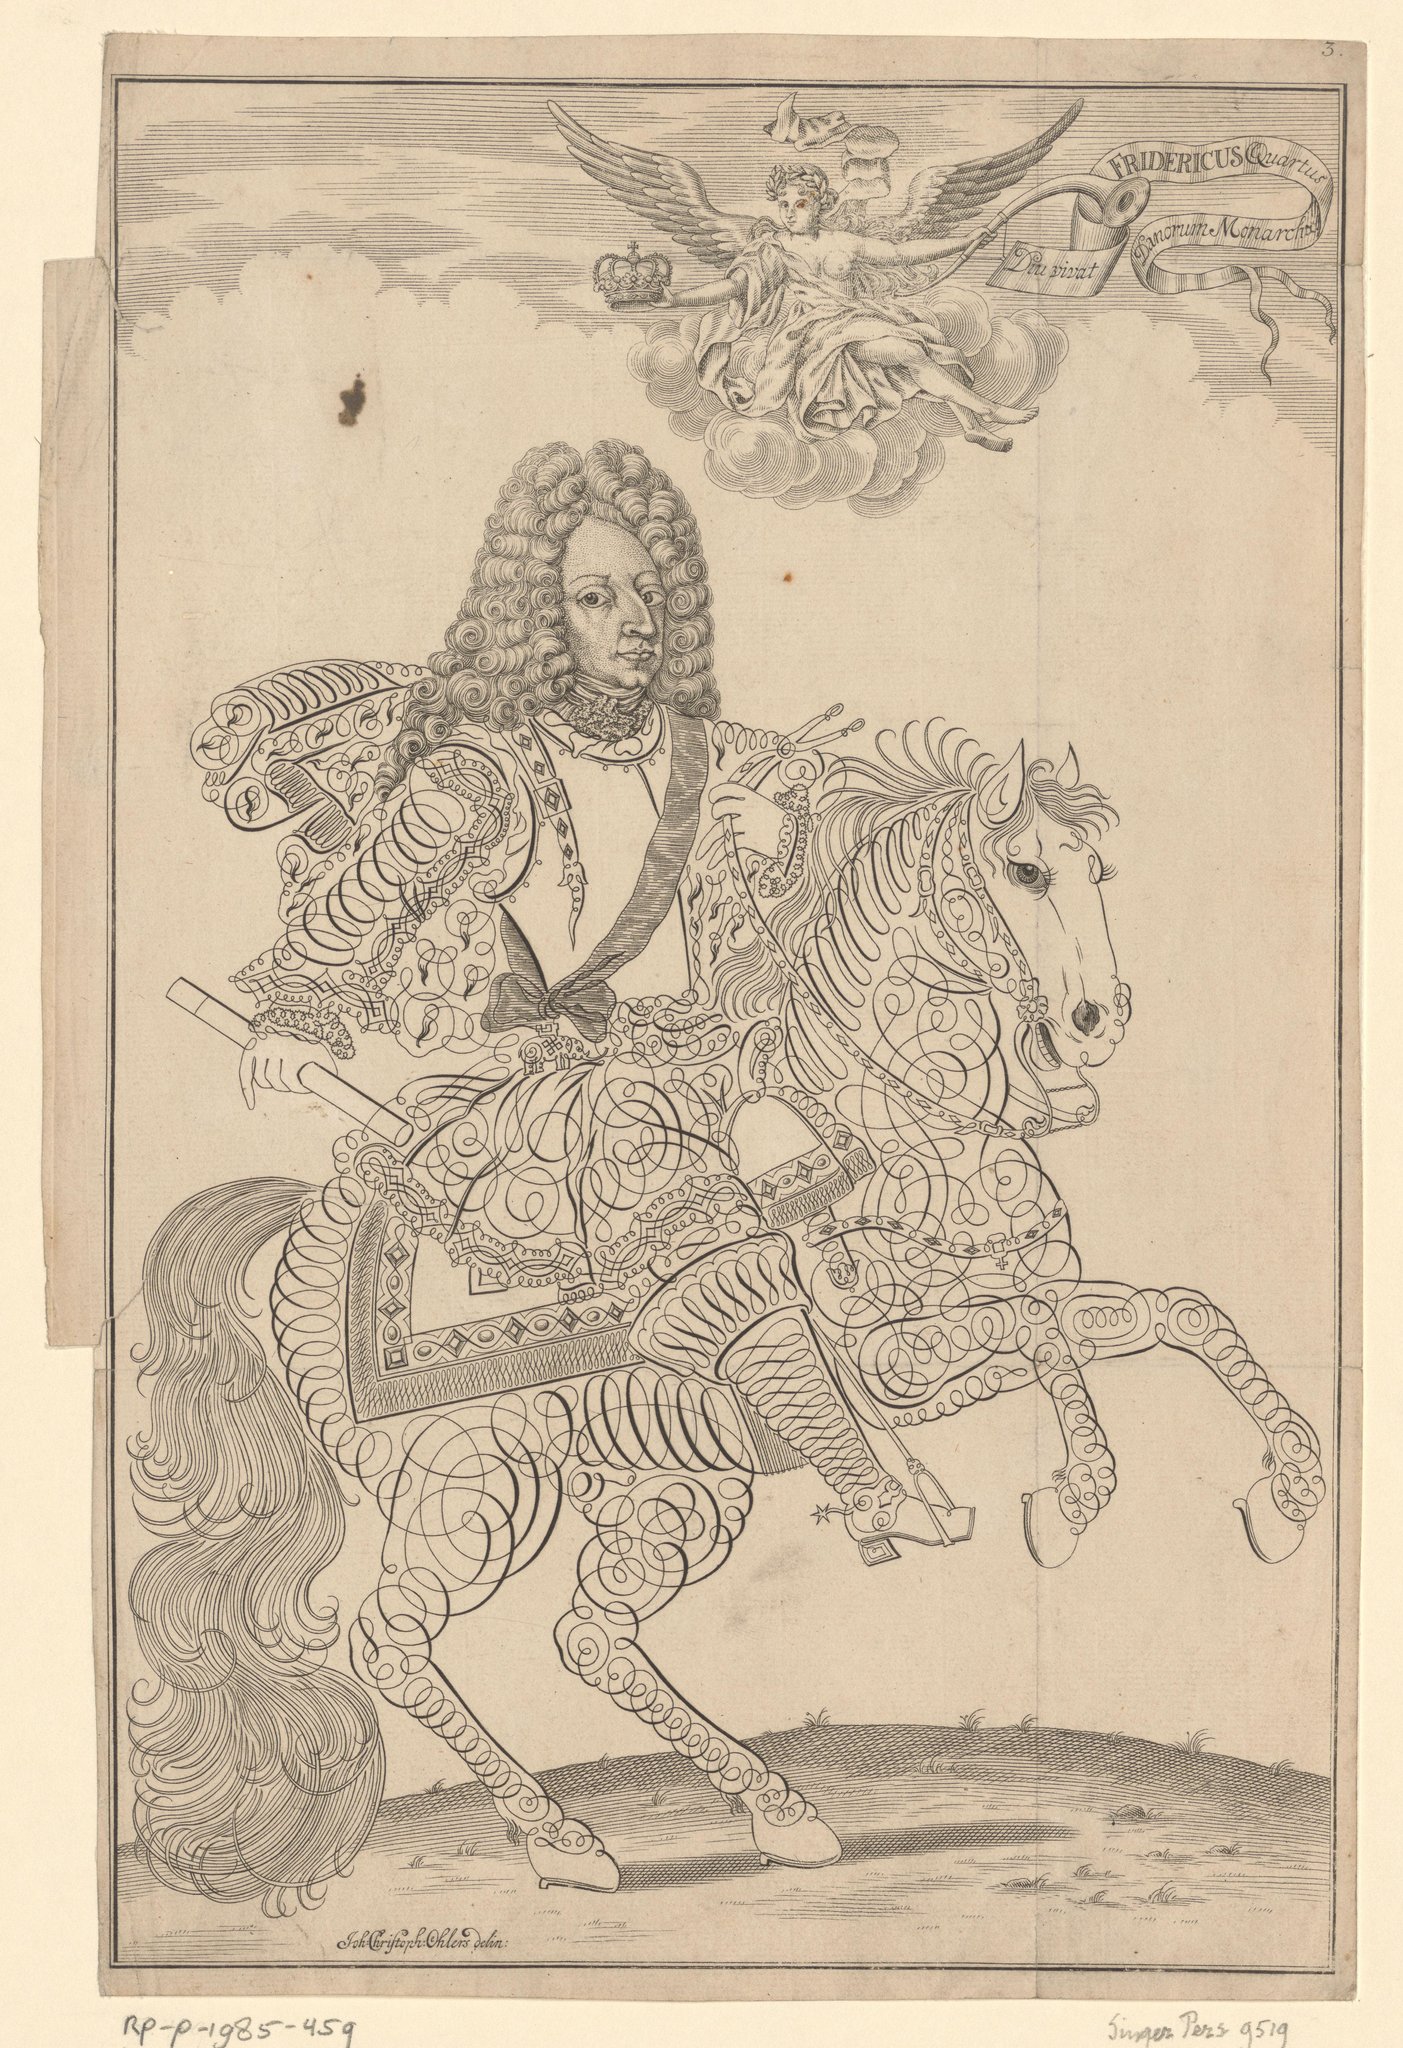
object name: print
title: Ruiterportret van Frederik IV van Denemarken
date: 1700-1730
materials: paper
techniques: engraving, etching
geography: germany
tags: copenhagen (city), frederik iv (koning van denemarken en noorwegen), equestrian state-portrait, crown (symbol of sovereignty), historical persons, calligraphy, king, angels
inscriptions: collector's mark: Lugt 2760, collector's mark: Lugt 2228